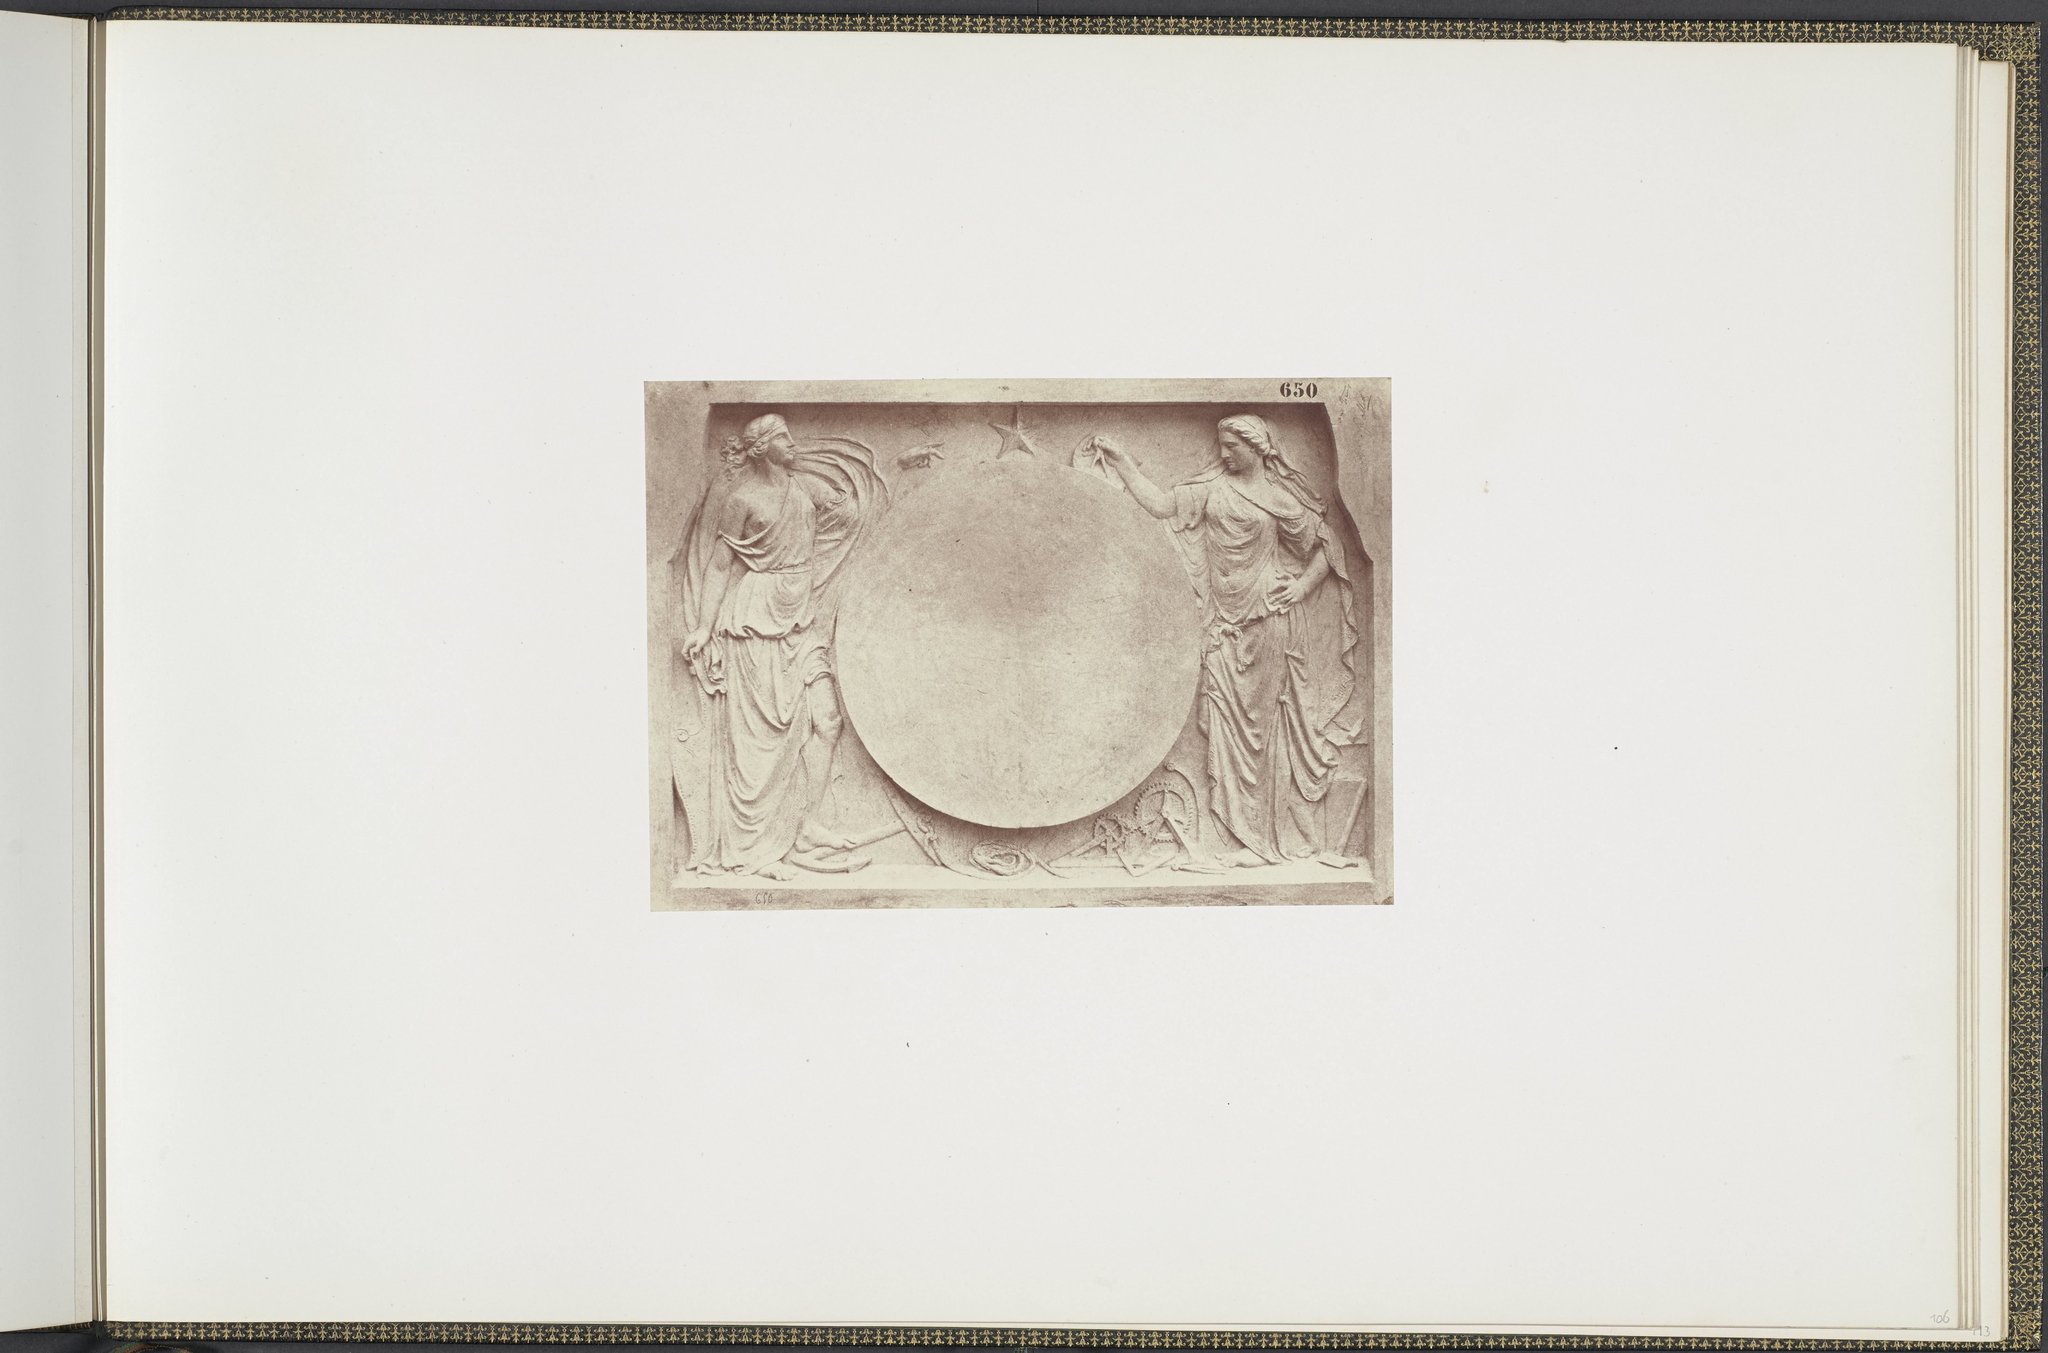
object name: photograph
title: Gipsmodellen voor beeldhouwwerken op het Palais du Louvre: "La Navigation commerciale et la Mécanique" door Joseph Pollet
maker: édouard denis baldus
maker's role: fotograaf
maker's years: 1813-1889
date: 1855-1857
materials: paper, photographic support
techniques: salted paper print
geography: paris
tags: piece of sculpture, reproduction of a piece of sculpture, permanent exhibition, museum, paris, tuileries palace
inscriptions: number: ‘650’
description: Onderdeel van Réunion des Tuileries au Louvre 1852-1857, album 1.